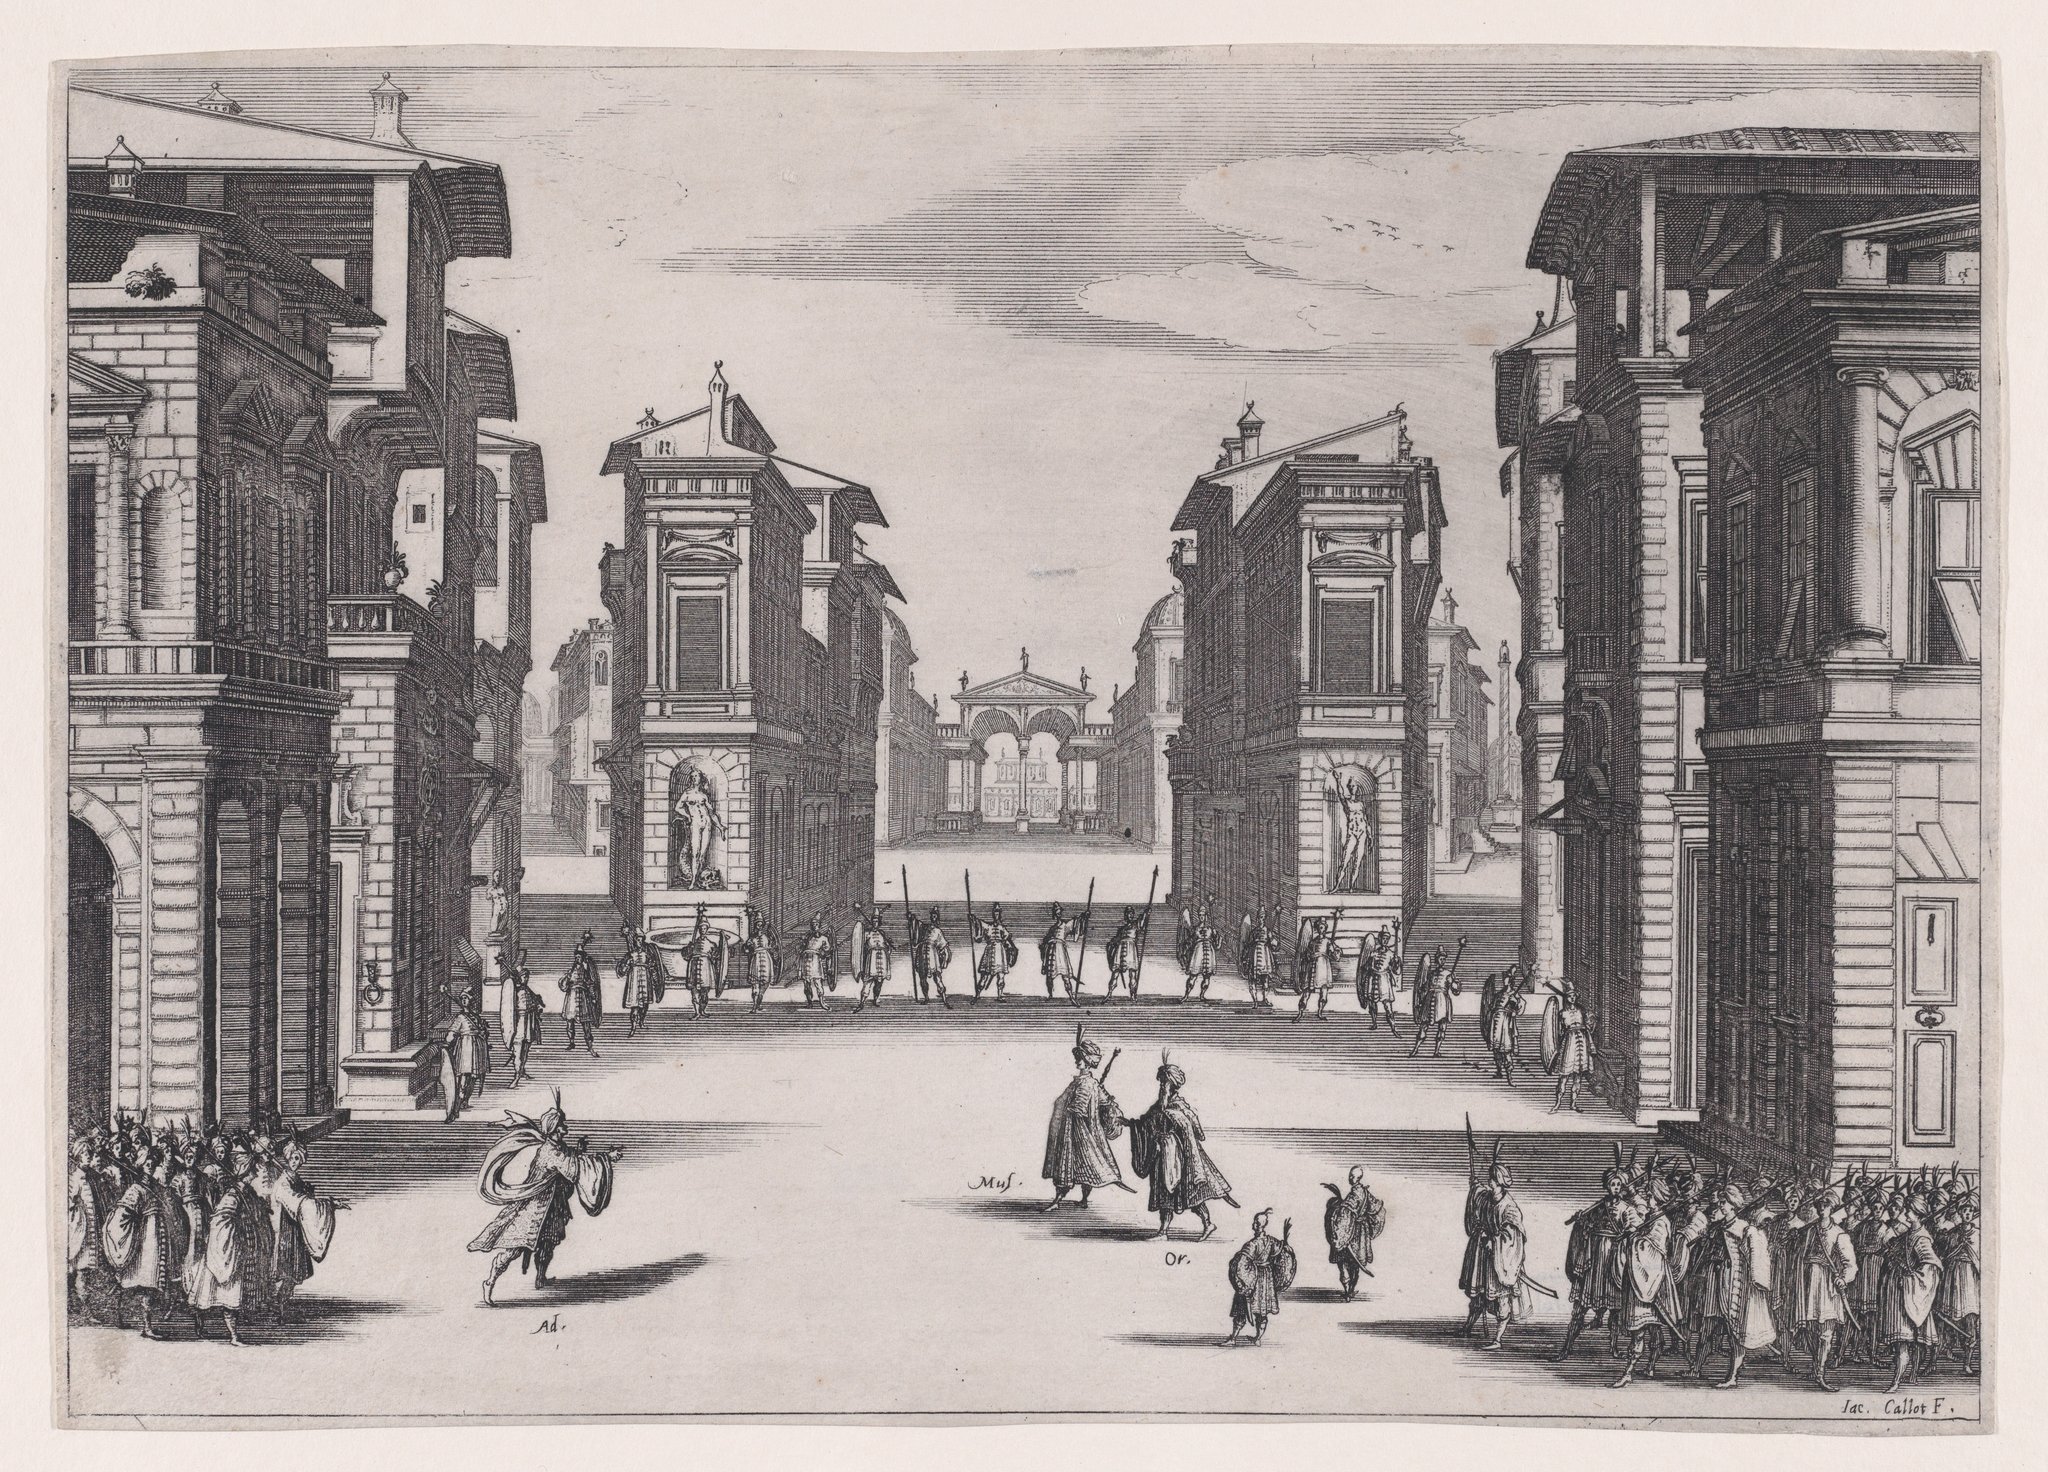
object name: print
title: Soliman, 3e Acte, from "Soliman"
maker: jacques callot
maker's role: artist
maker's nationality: french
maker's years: 1592-1635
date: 1620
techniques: engraving, etching